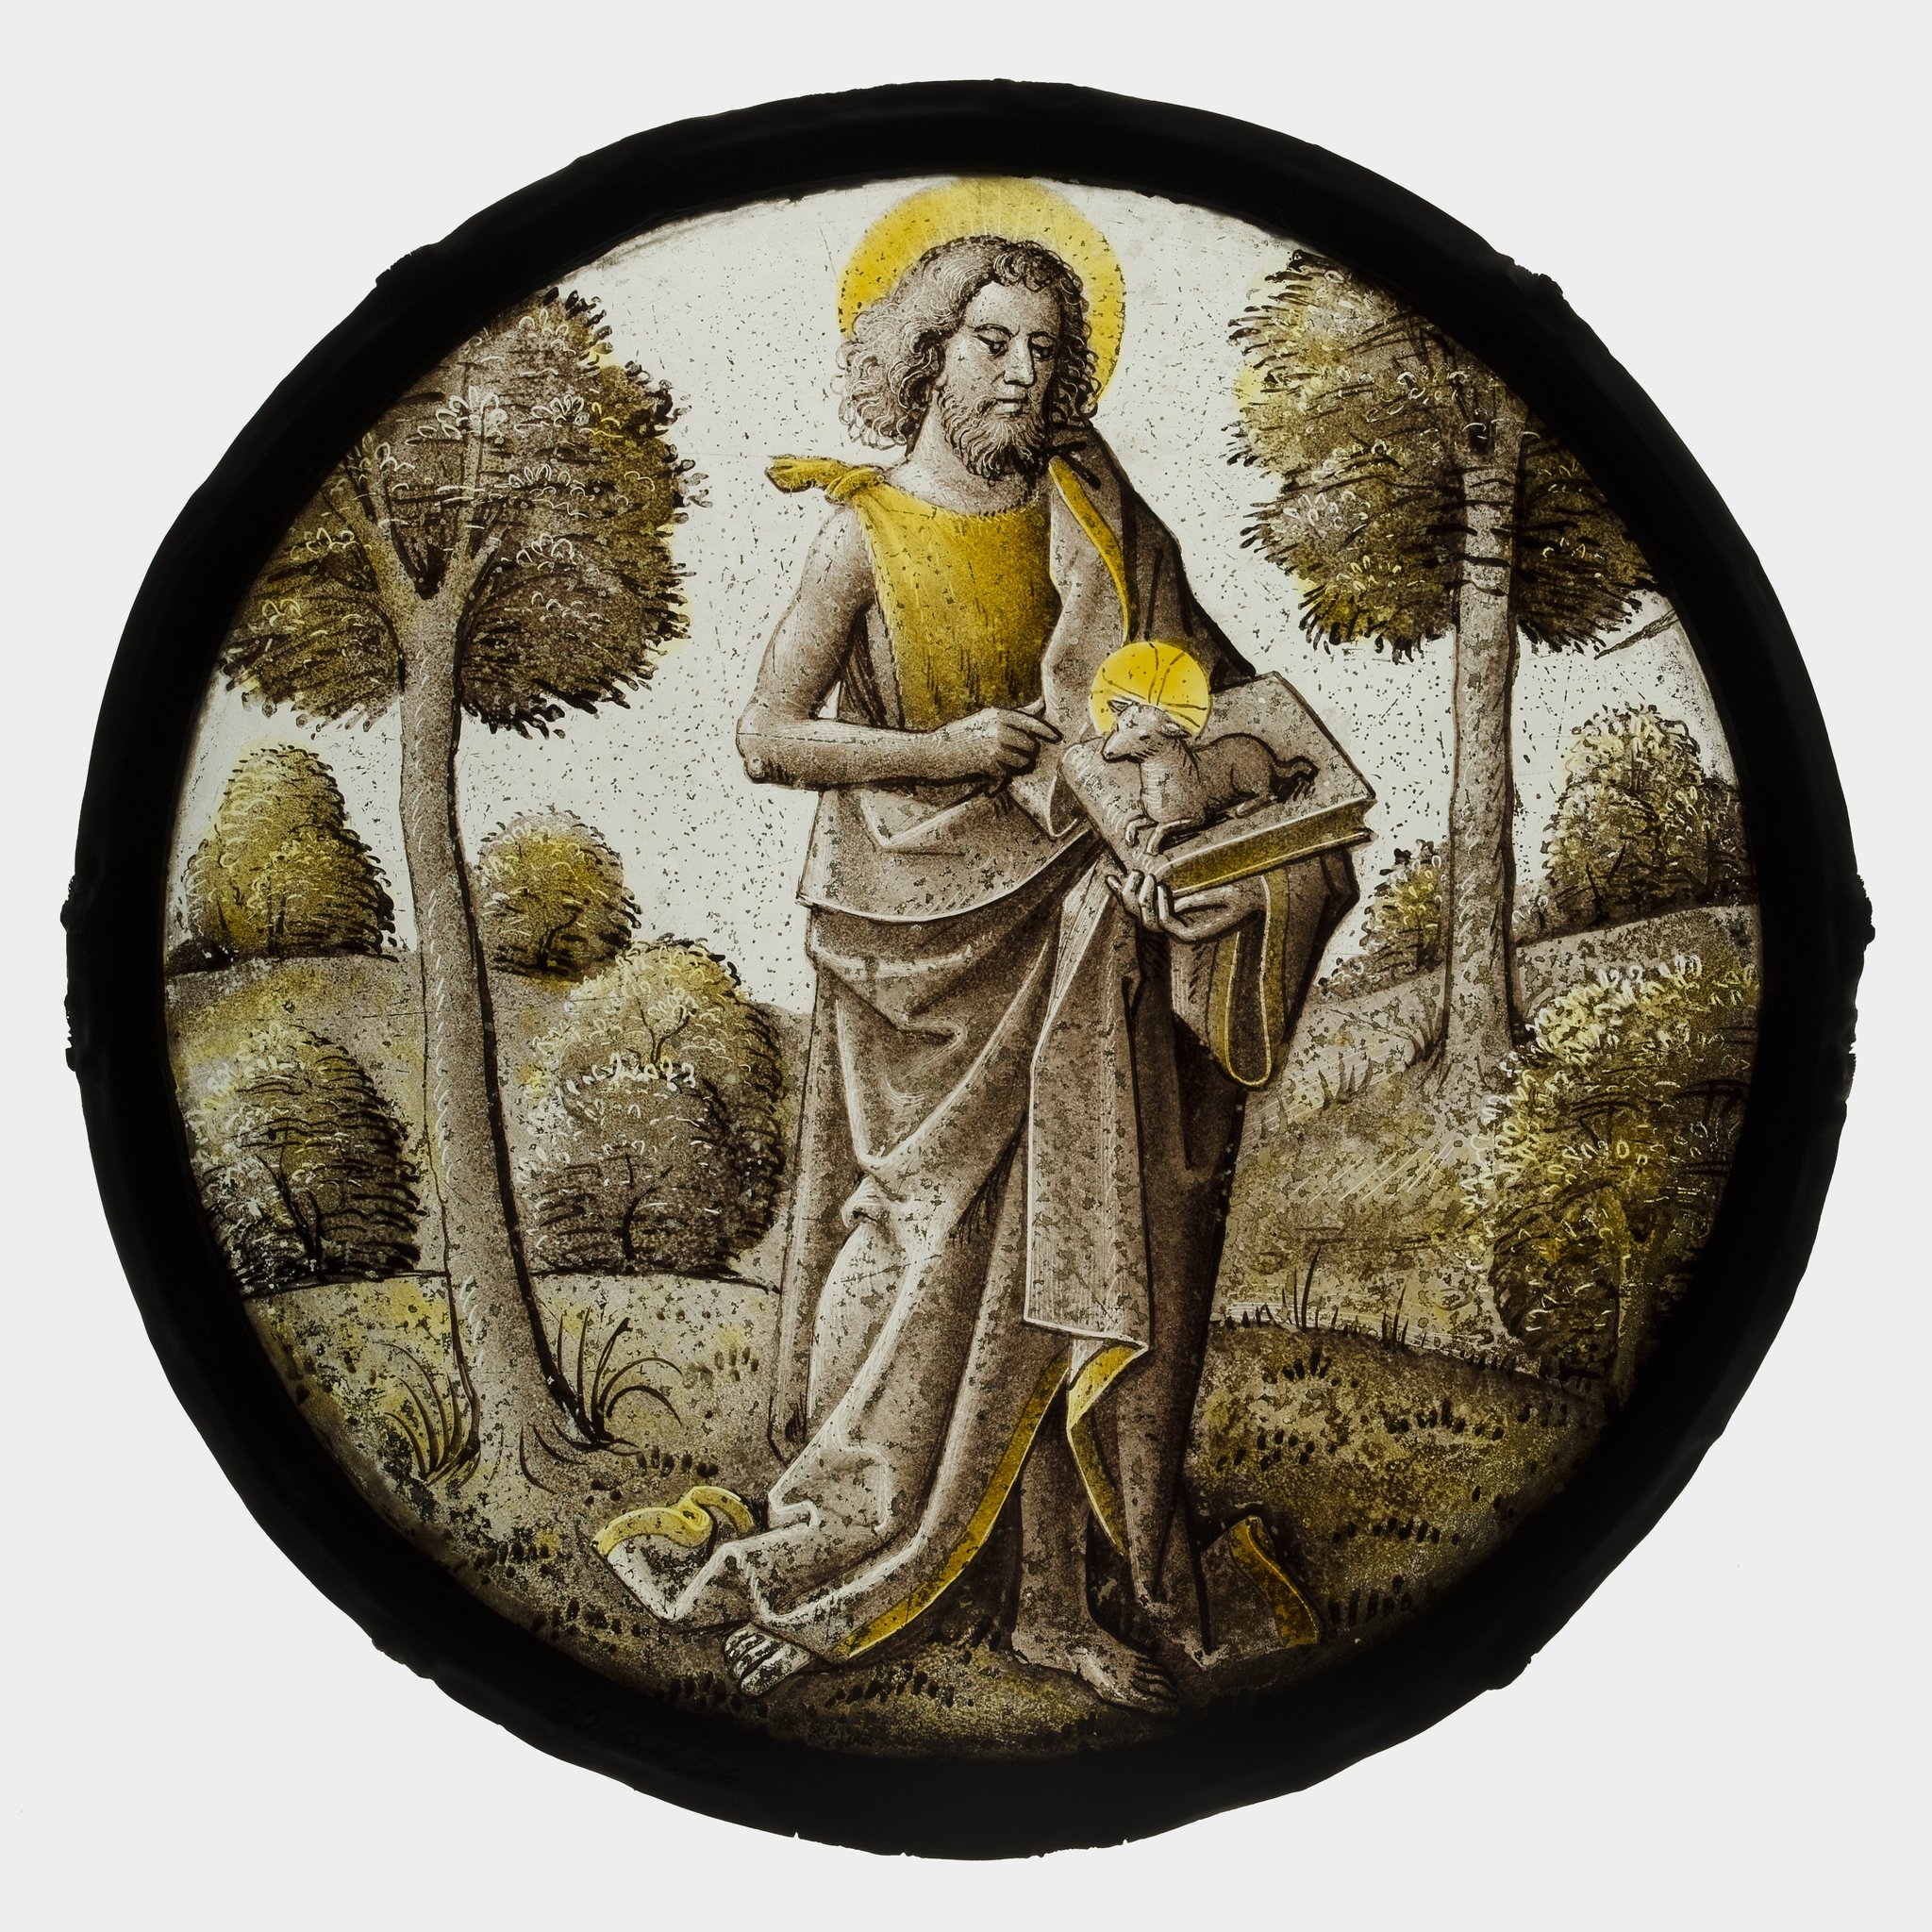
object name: roundel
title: Roundel with Saint John the Baptist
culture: south netherlandish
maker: pseudo-ortkens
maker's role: artist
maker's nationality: south netherlandish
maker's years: 1500-1530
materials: glass, paint, pigment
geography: south netherlands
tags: lambs,saint john the baptist